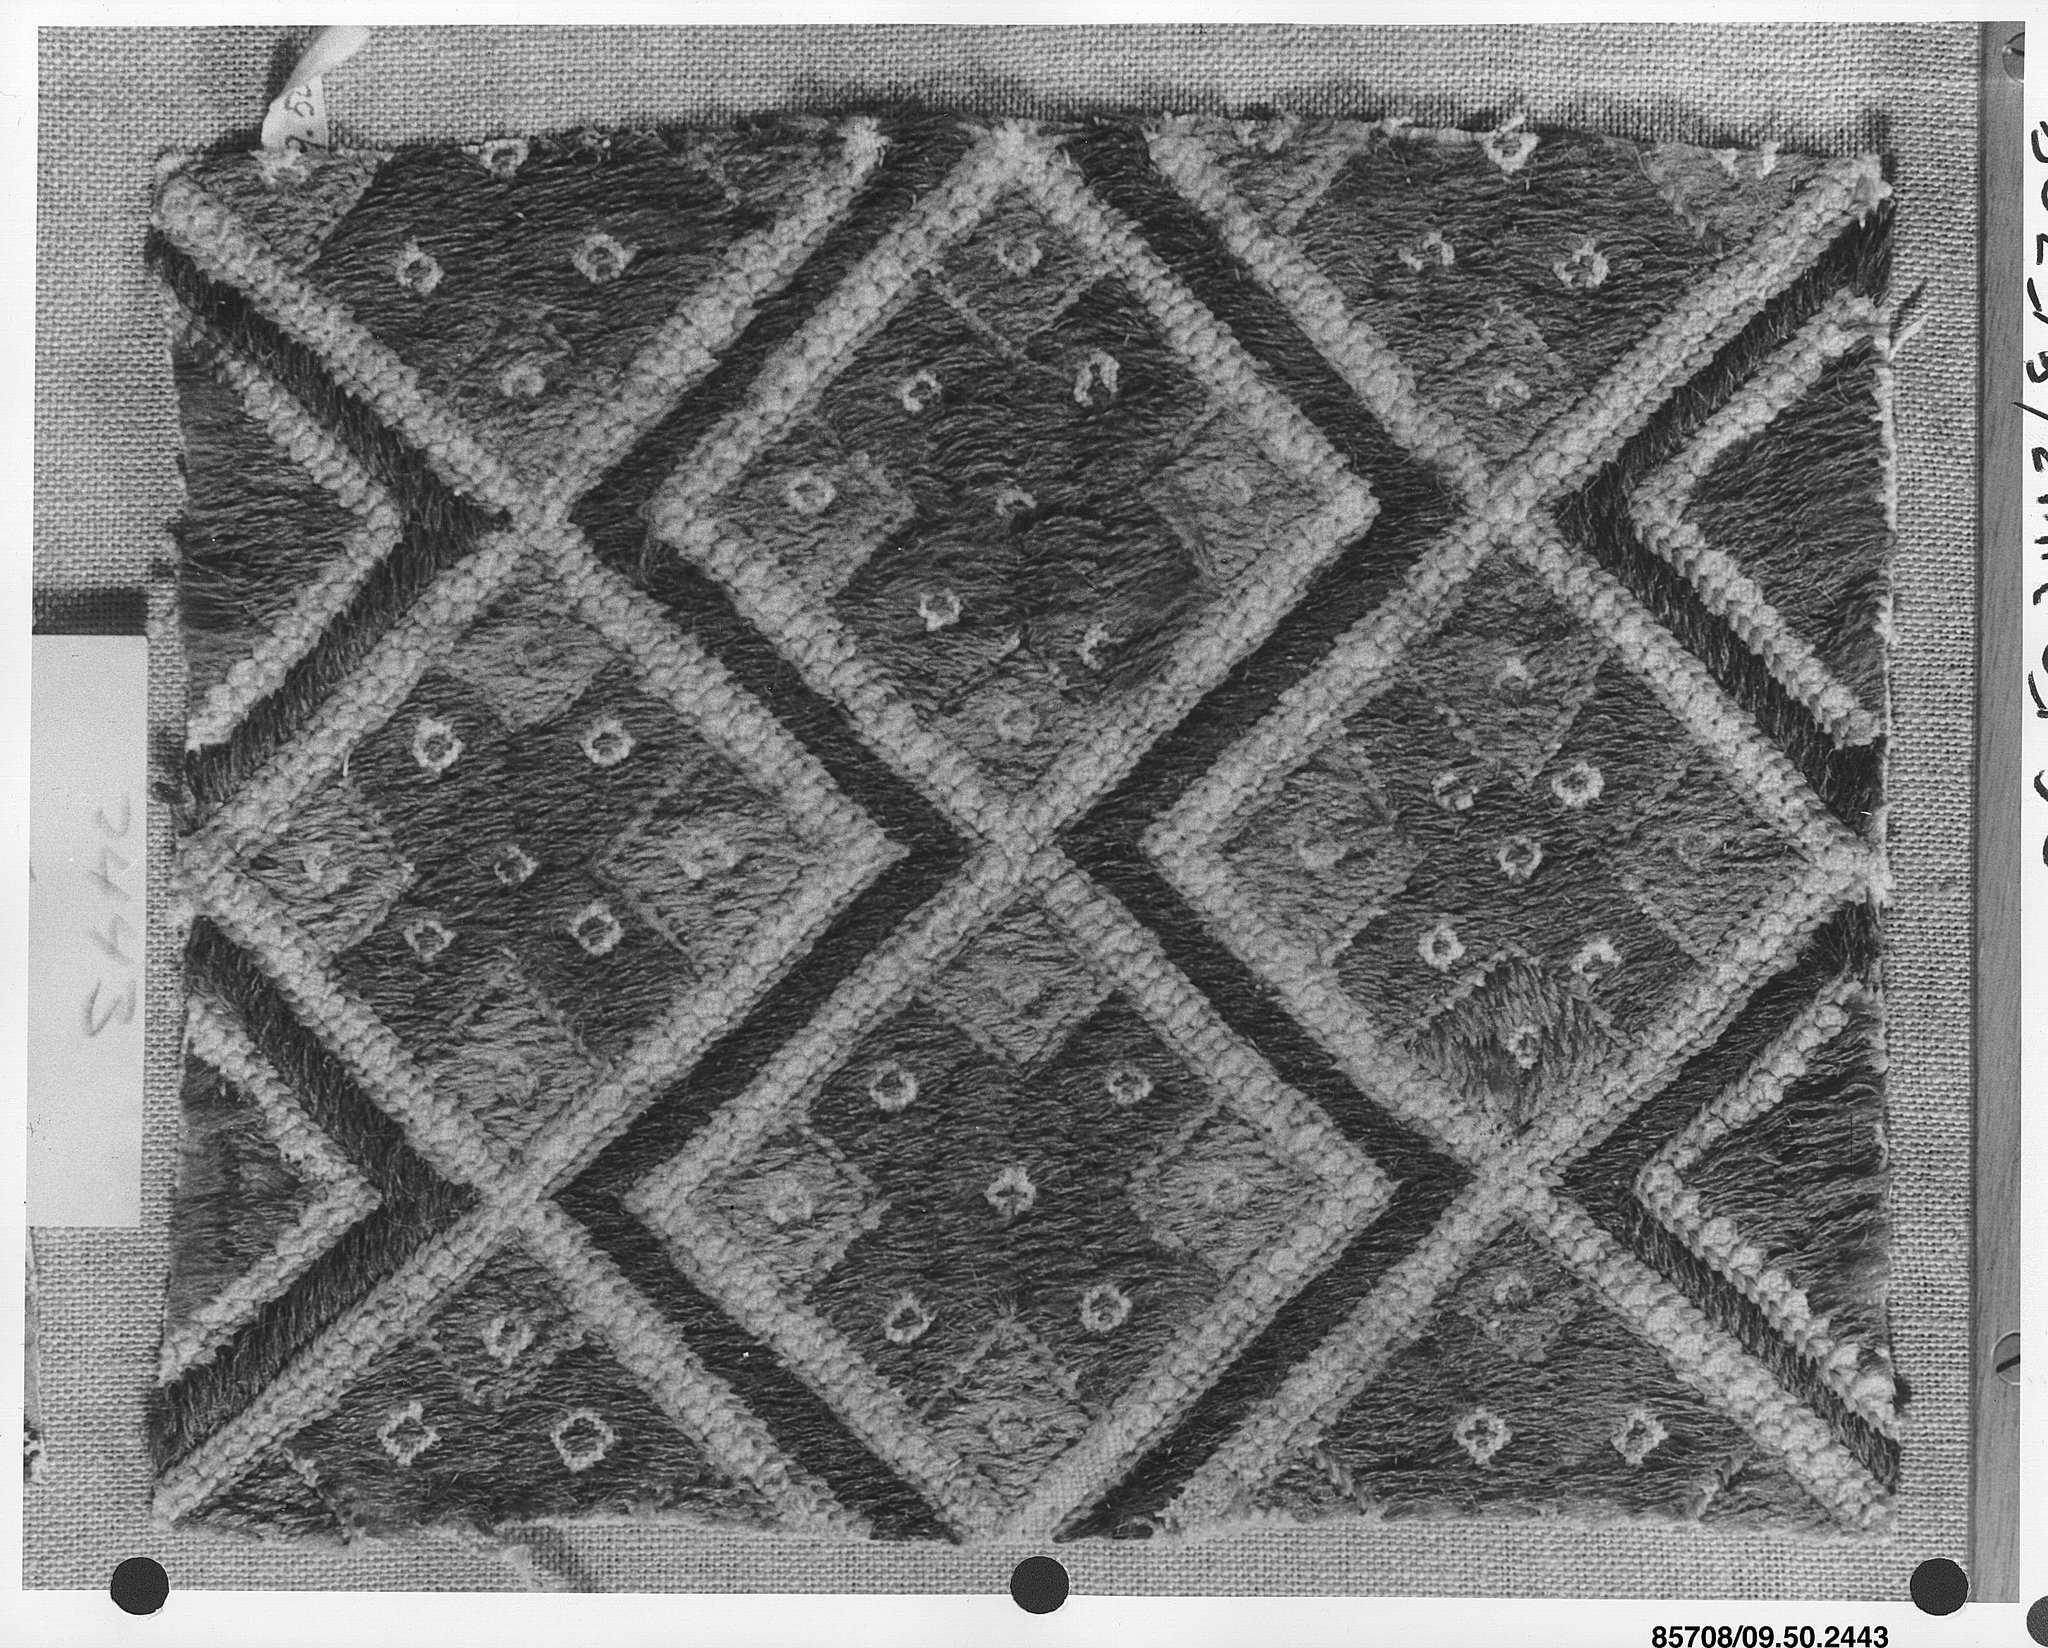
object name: fragment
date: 1701-1900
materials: canvas, wool